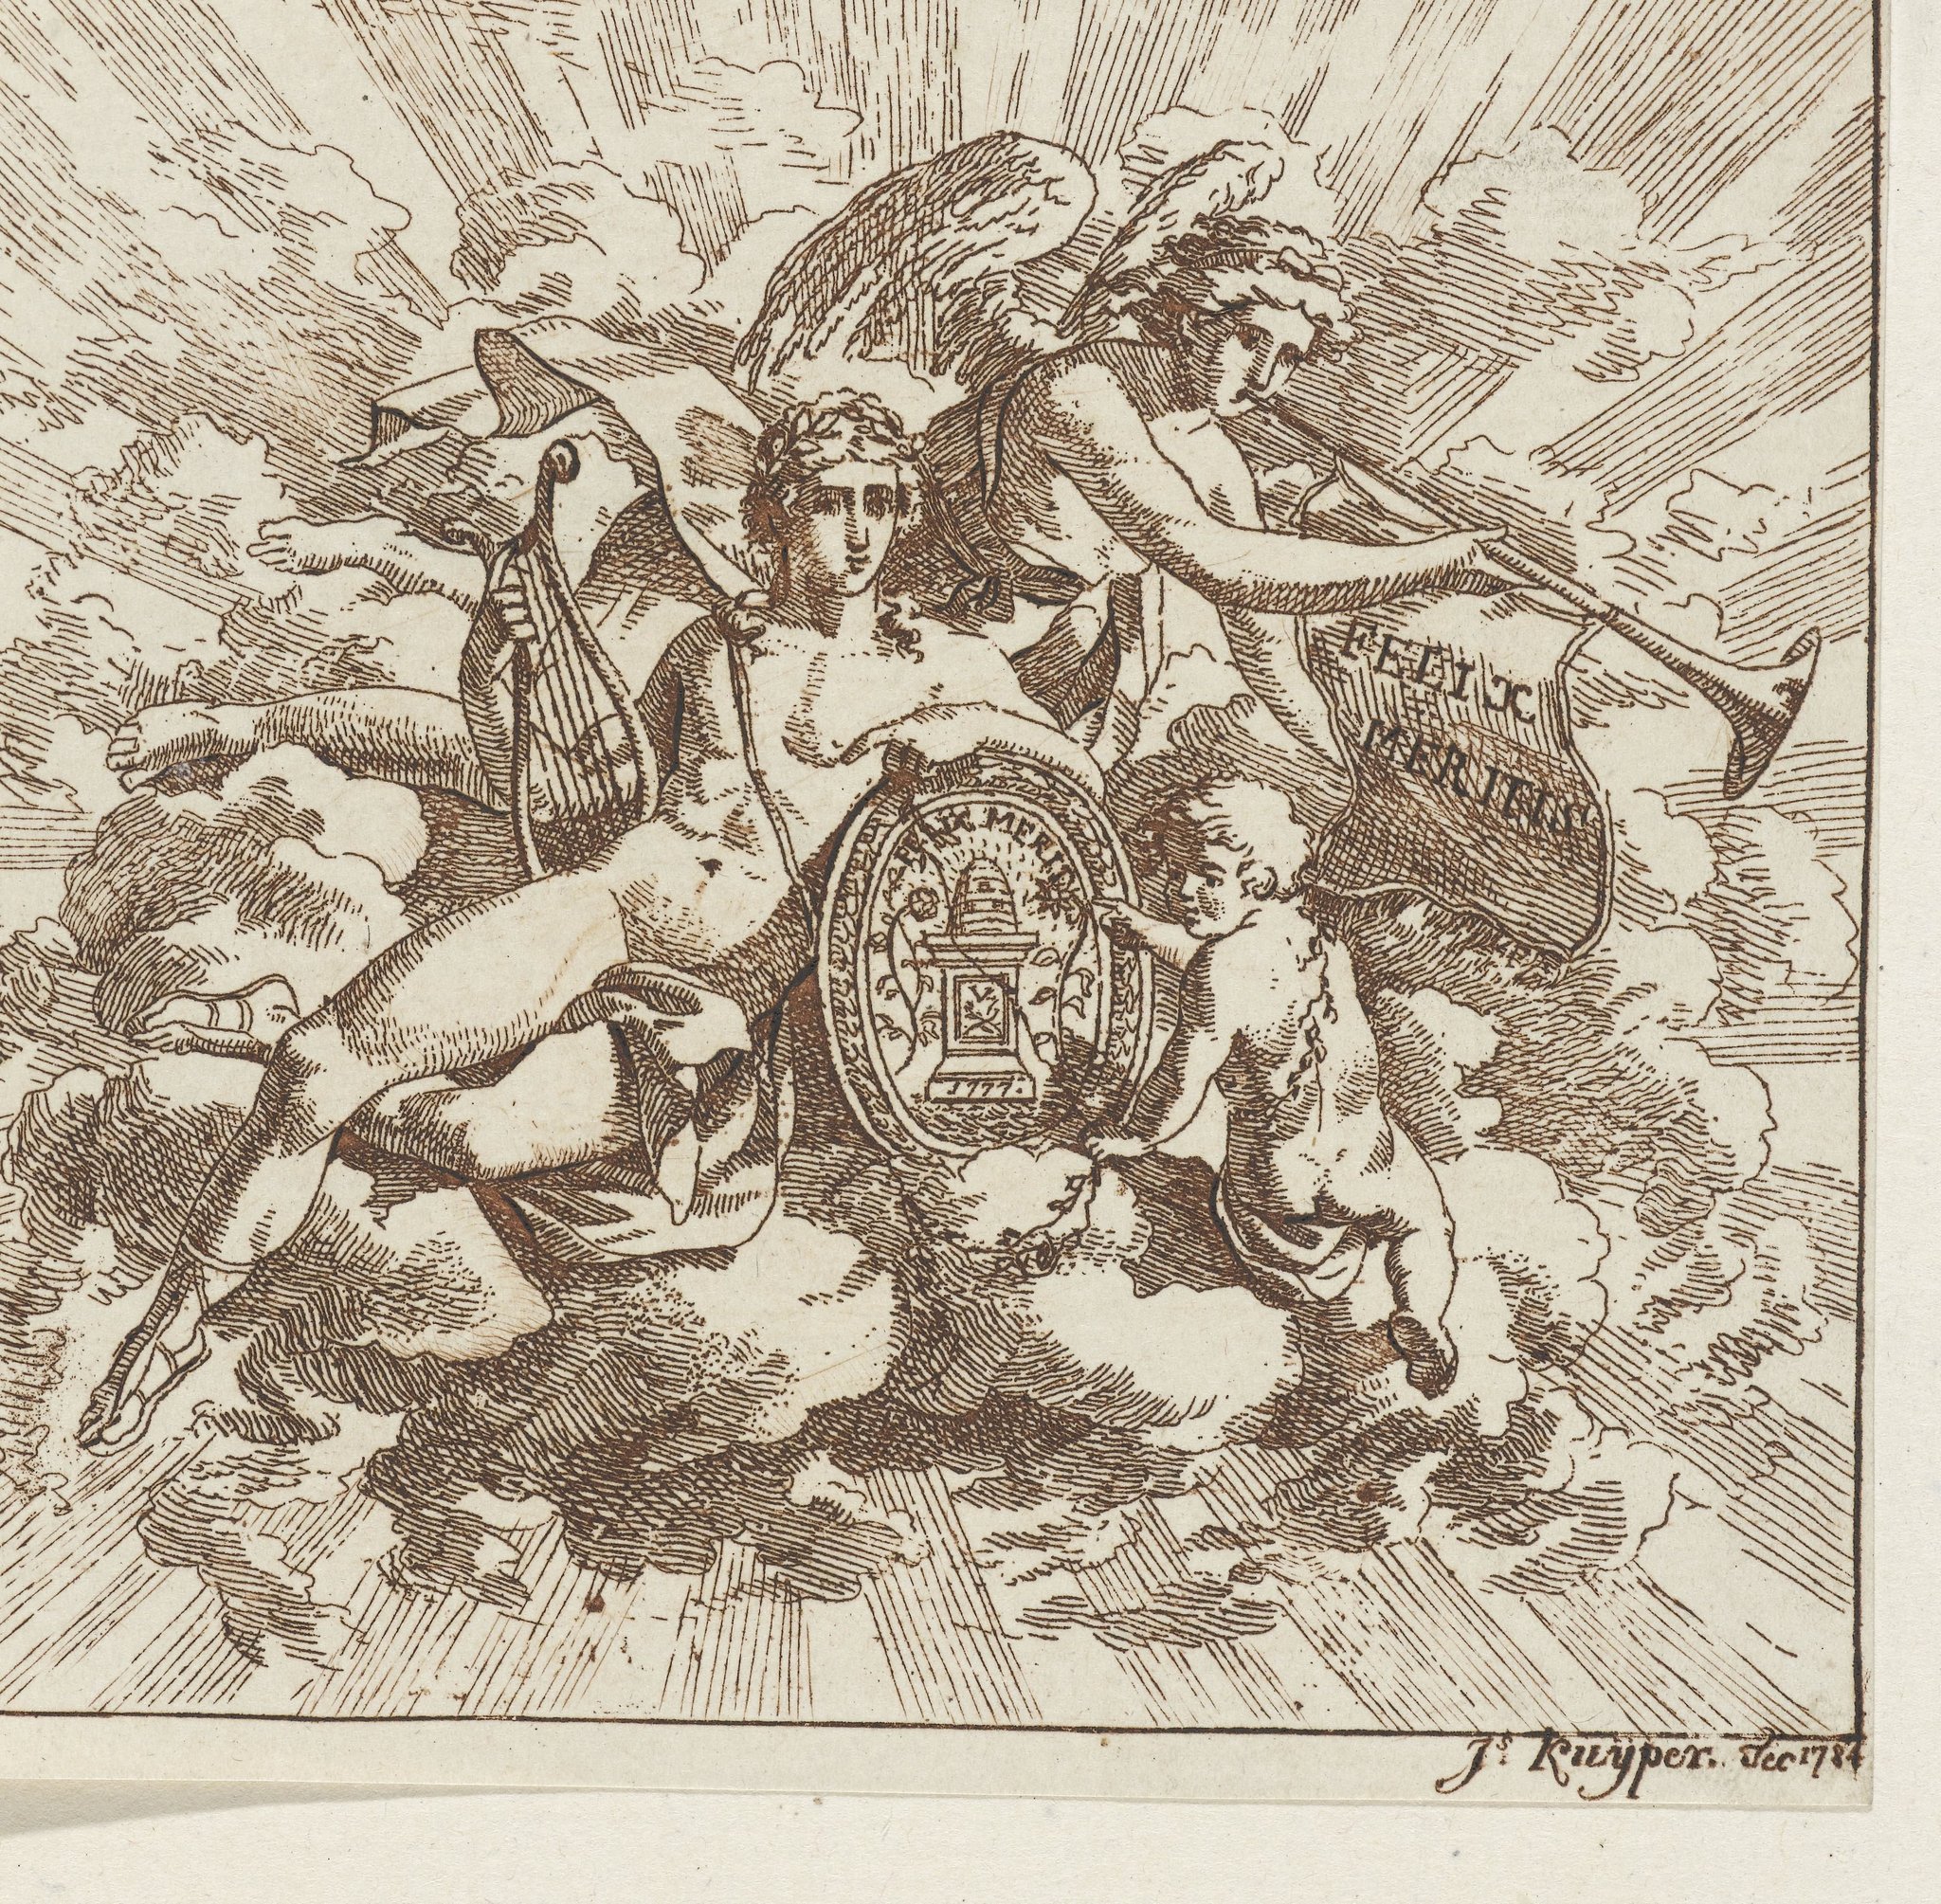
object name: print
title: Allegorische compositie op Felix Meritis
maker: jacques kuyper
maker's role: draughtsman, print maker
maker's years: 1761-1808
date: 1784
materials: paper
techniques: etching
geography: amsterdam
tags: (story of) apollo (phoebus), bee-hive, fame; 'fama', 'fama buona', 'fama chiara' (ripa), cupids: 'amores', 'amoretti', 'putti', amsterdam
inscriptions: collector's mark: Lugt 2760, collector's mark: Lugt 2228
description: Allegorische compositie op Felix Meritis met rechts de gevleugelde Faam die op de loftrompet blaast. Links rust Apollo, op de wolken gezeten, met de linkerarm op het blasoen van Felix Meritis dat ook door een putto wordt vastgehouden.